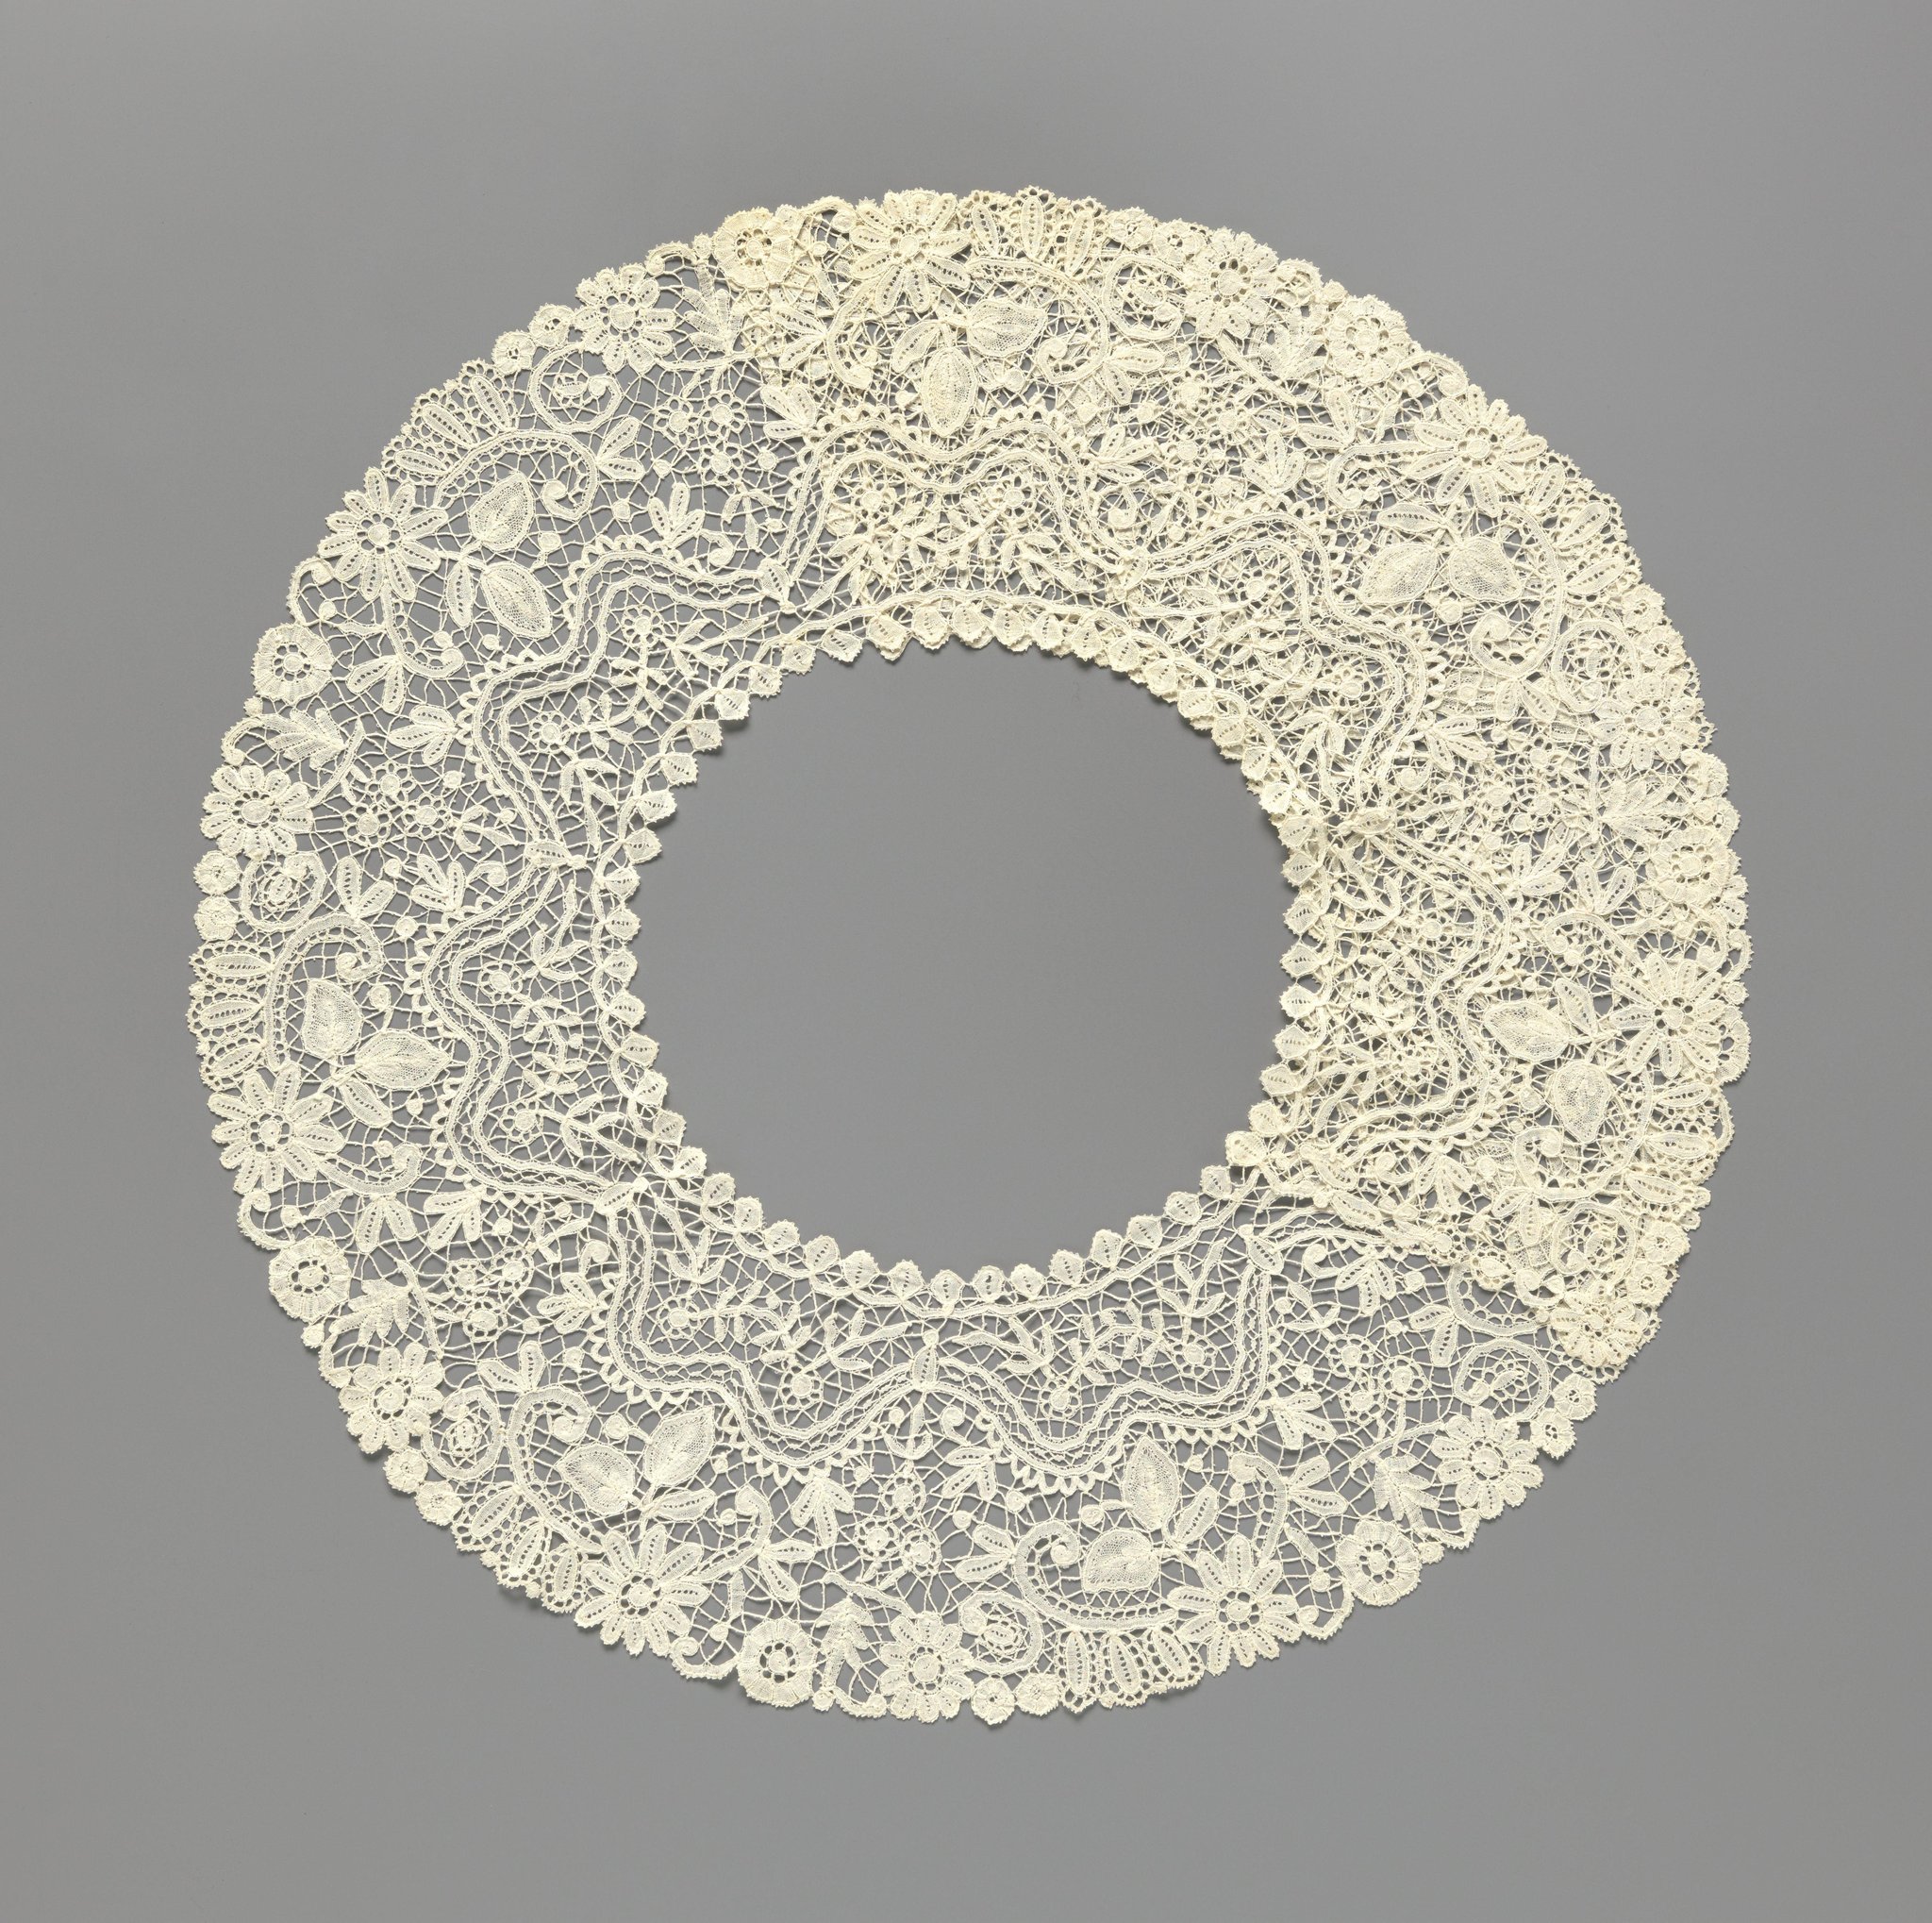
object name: bertha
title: Berthe van kloskant met golflijn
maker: Anonymous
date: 1854-1900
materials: linen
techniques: lace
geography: sluis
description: Berthe van naturelkleurige kloskant: Sluise duchesse. Een dubbele en geschulpte golflijn loopt langs de binnenrand. Langs de buitenrand staat op een zeer open vlechtengrond een lopend patroon met een margrietje, een drieblad en een c-voluut. Een klein tussenpatroon vertoont een aan de golflijn hangend trosje en een margrietje.